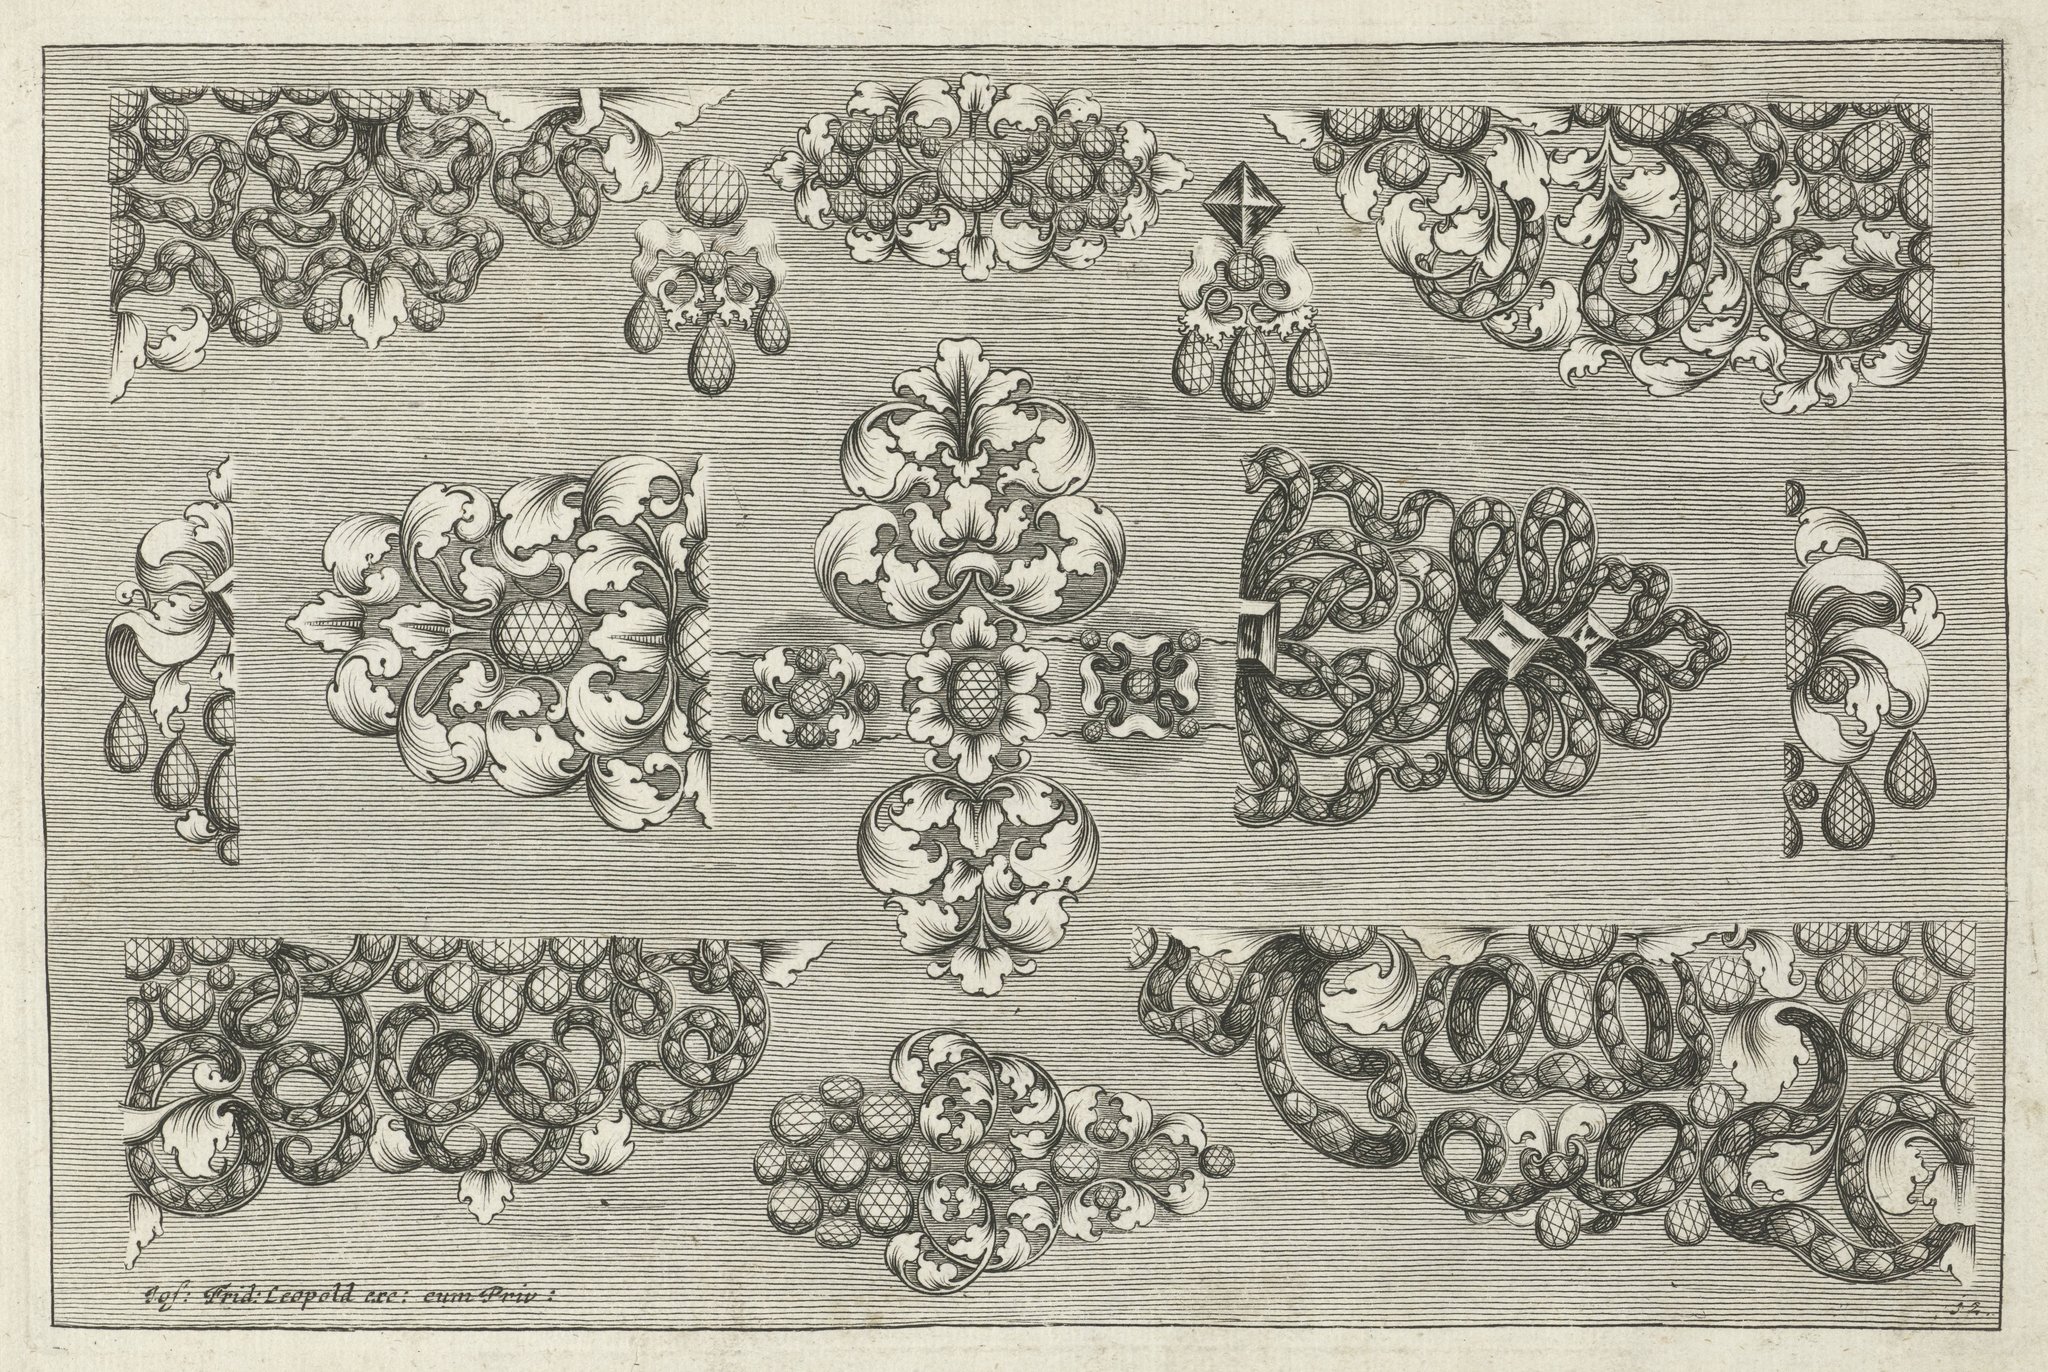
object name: ornament print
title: Dertien ontwerpen voor juwelen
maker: joseph friedrich leopold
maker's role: print maker, publisher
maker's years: 1668-1726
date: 1695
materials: paper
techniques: engraving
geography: germany